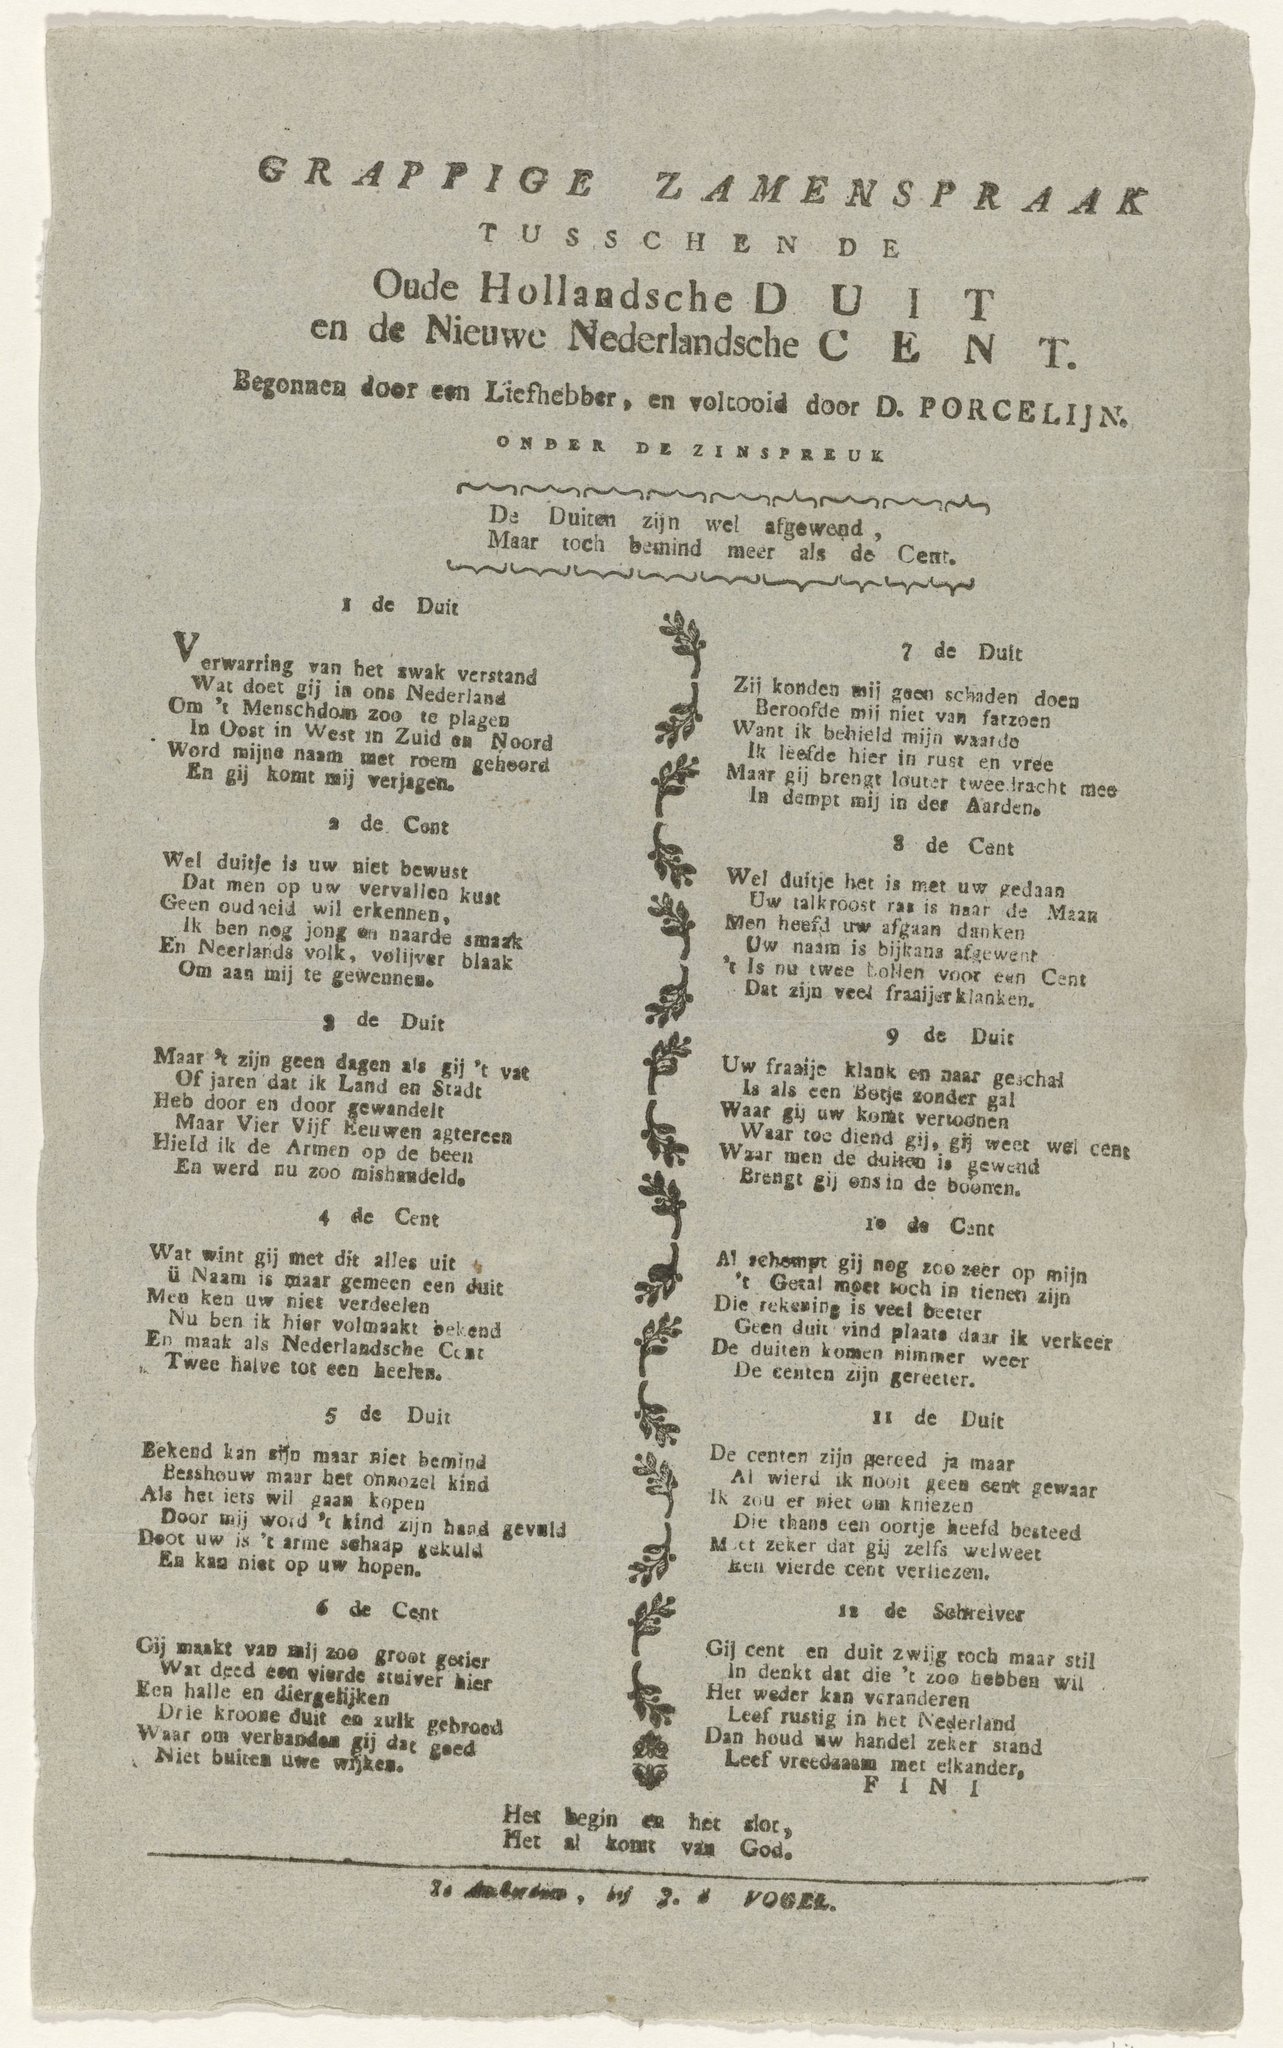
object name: text sheet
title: Samenspraak tussen de oude duit en de nieuwe cent, ca. 1816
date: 1816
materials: paper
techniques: letterpress printing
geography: amsterdam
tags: coin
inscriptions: collector's mark: Lugt 2228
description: Tekstblad met een samenspraak tussen de oude Hollandse duit en de nieuwe Nederlandse cent, ca. 1816. Tekst in twaalf verzen. Waarschijnlijk naar aanleiding van de Muntwet van 18 september 1816 waarmee het decimale muntstelsel in Nederland werd ingevoerd.